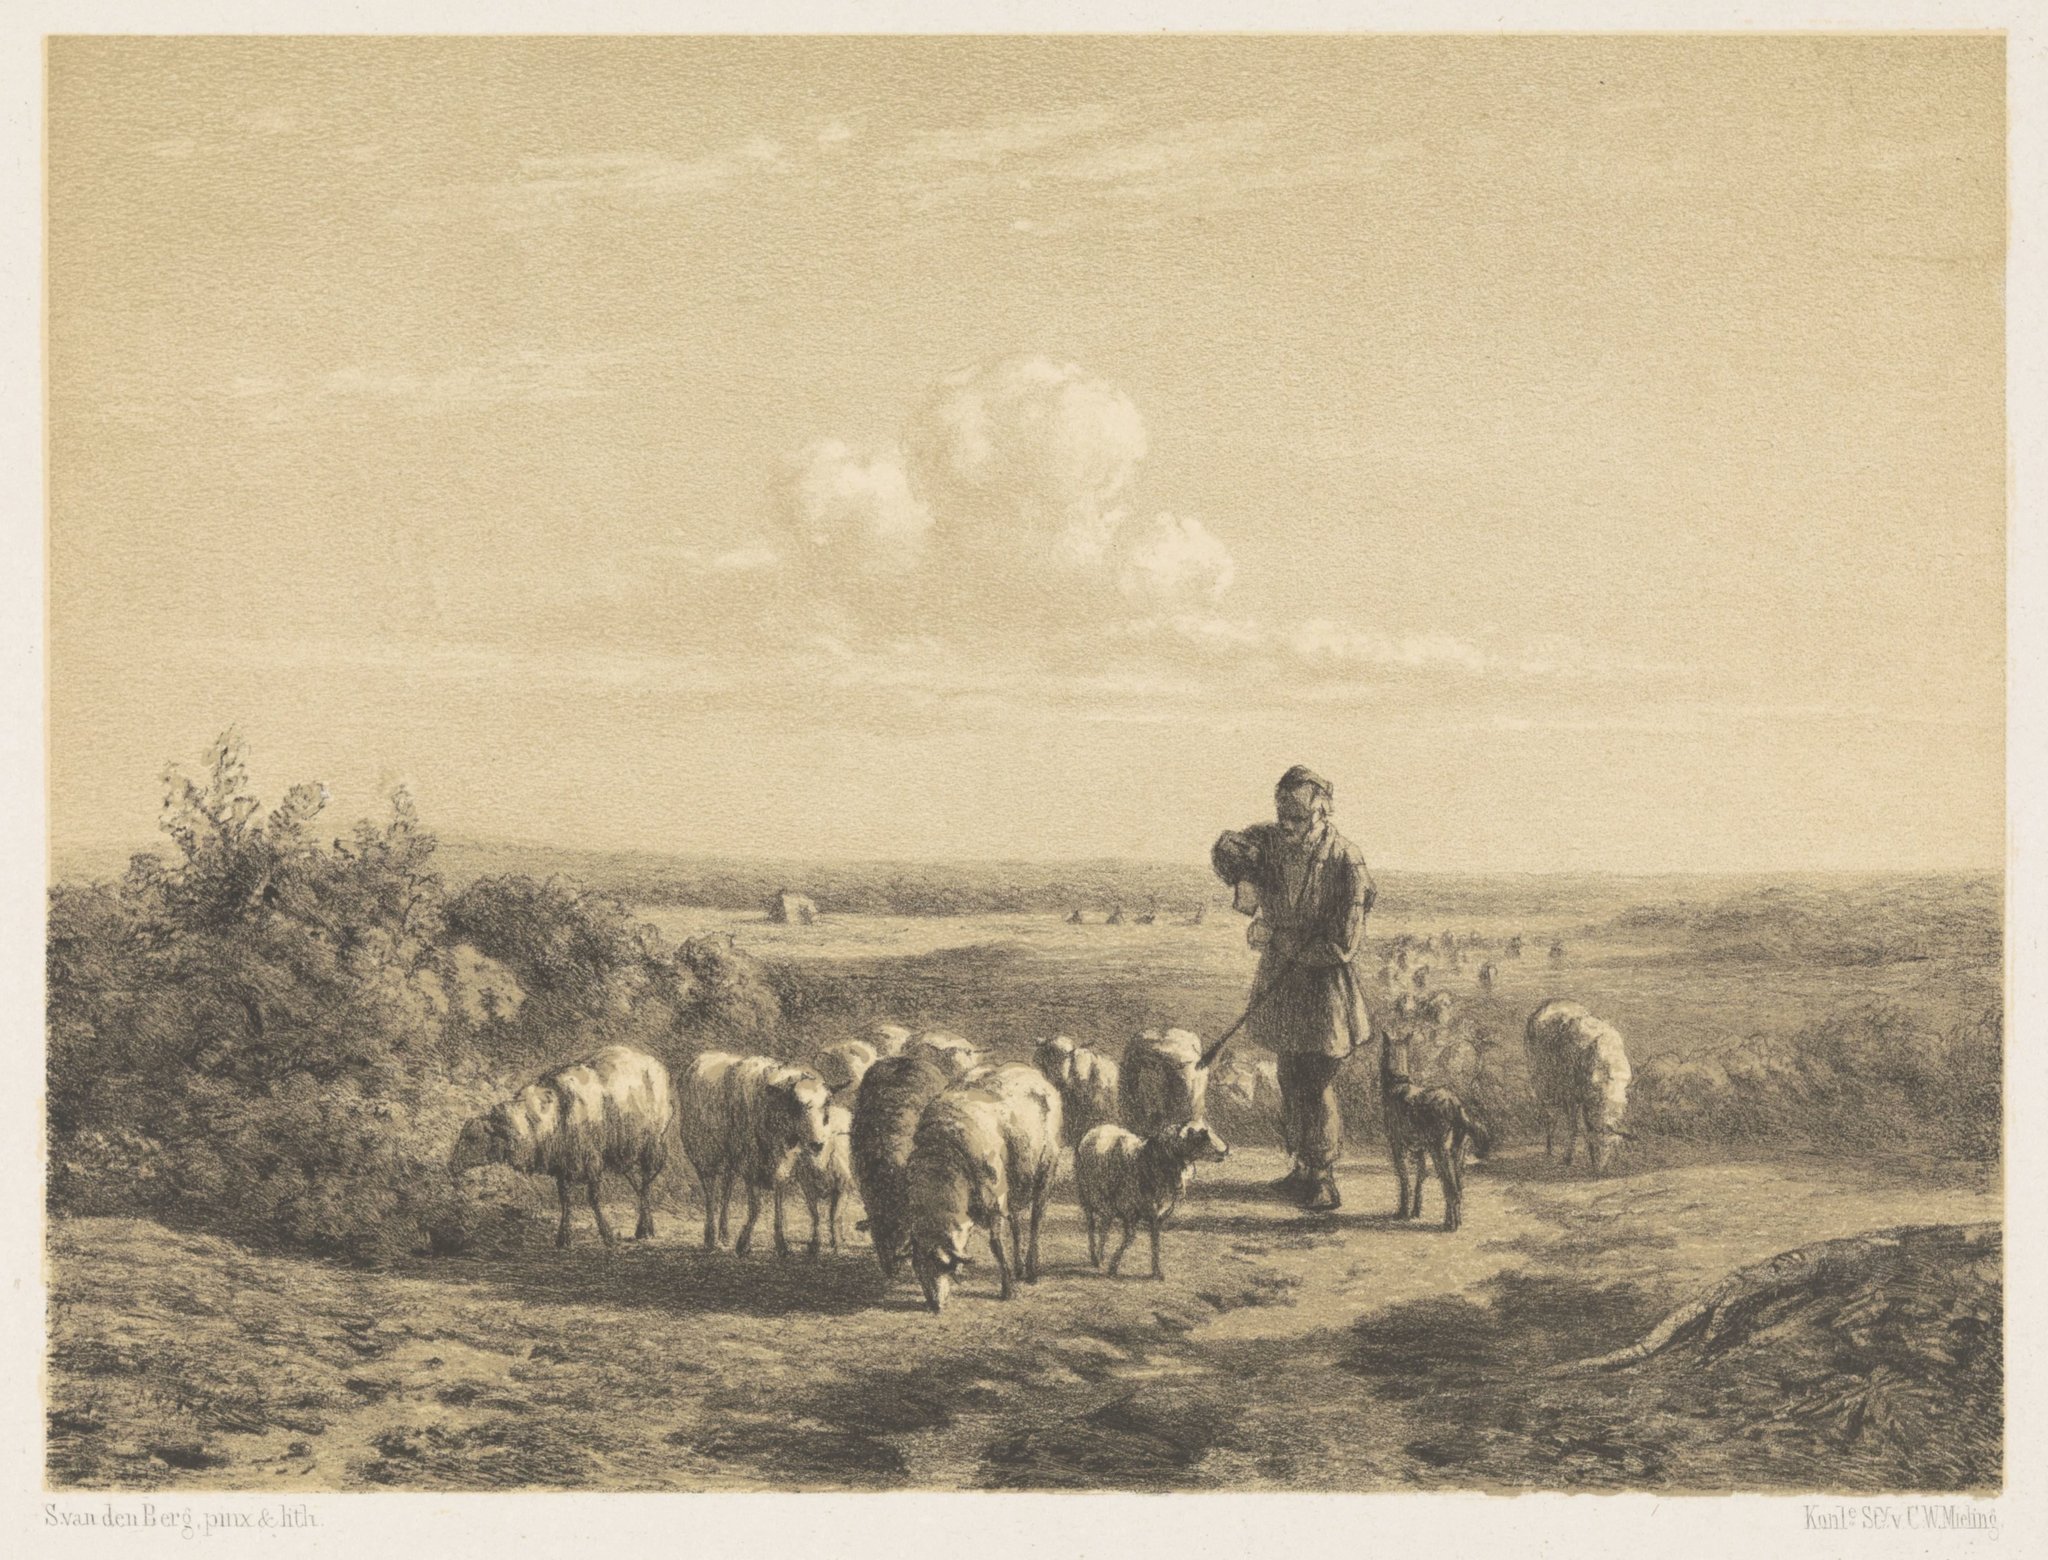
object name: print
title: Herder met zijn schapen op de hei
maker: simon van den berg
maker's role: draughtsman, print maker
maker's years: 1812-1891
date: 1822-1891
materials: paper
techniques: tone lithography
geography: netherlands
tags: herding, herdsman, herdswoman, shepherd, shepherdess, cowherd, etc., meadow, pasture, sheep, dog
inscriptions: collector's mark: Lugt 2228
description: Deze staat bevat de namen van de prentmaker, drukkker en de kleur van het toonblok.